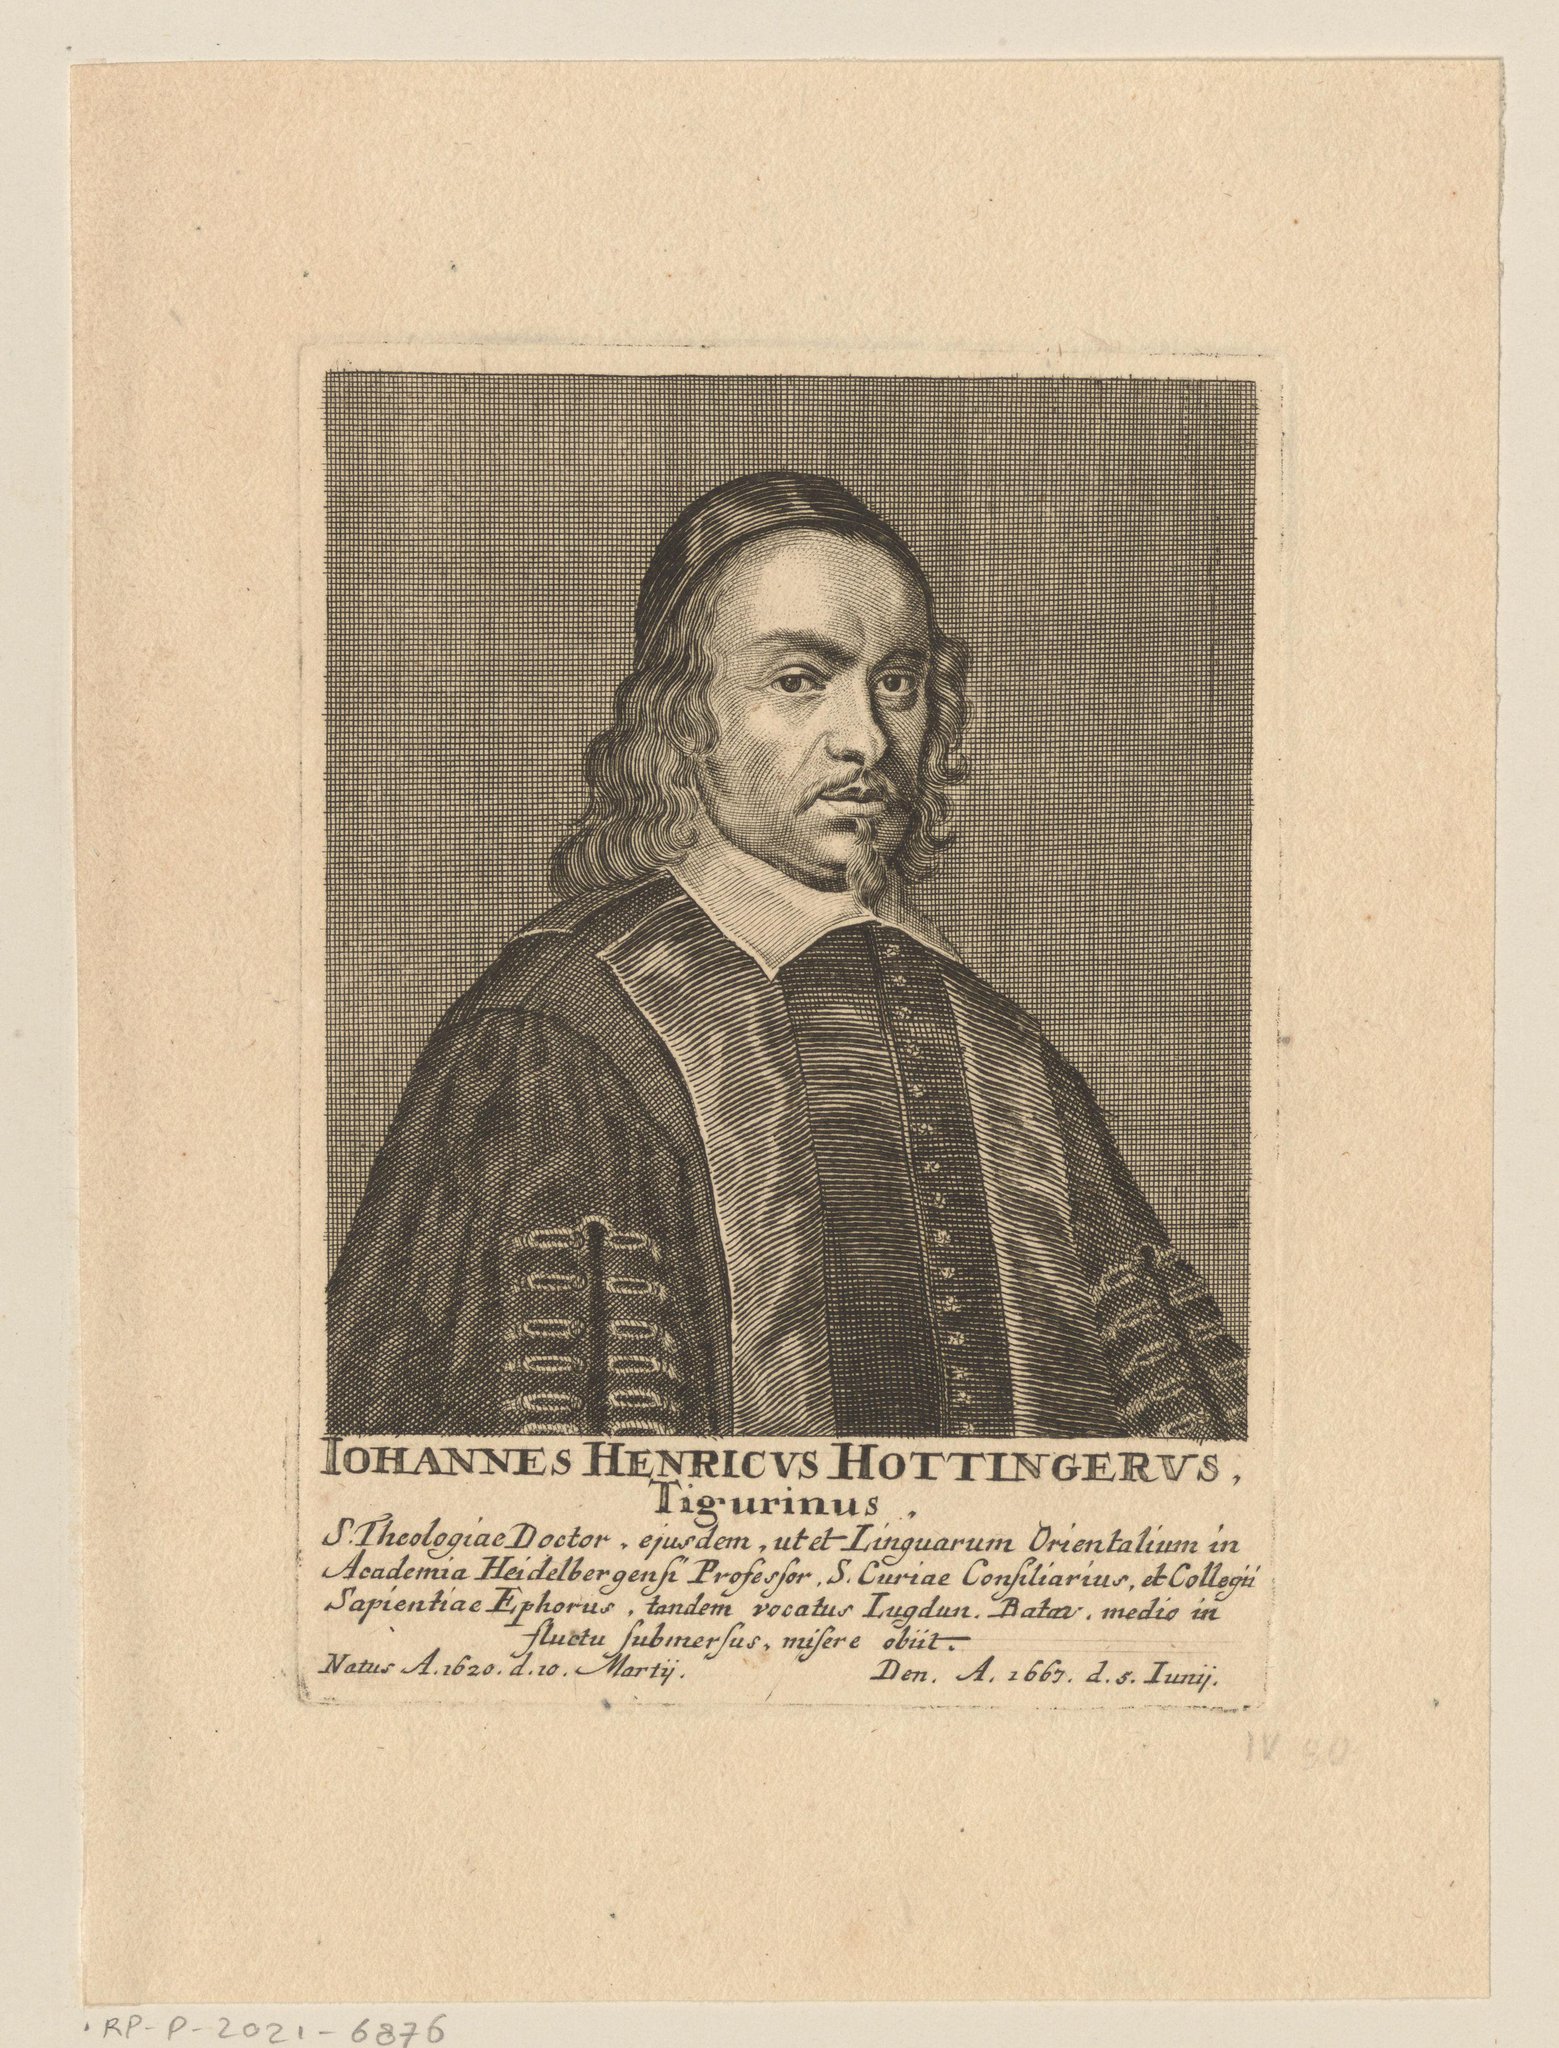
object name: print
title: Portret van Johann Heinrich Hottinger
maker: Anonymous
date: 1700-1725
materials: paper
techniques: engraving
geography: nuremberg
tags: theologian, historical persons